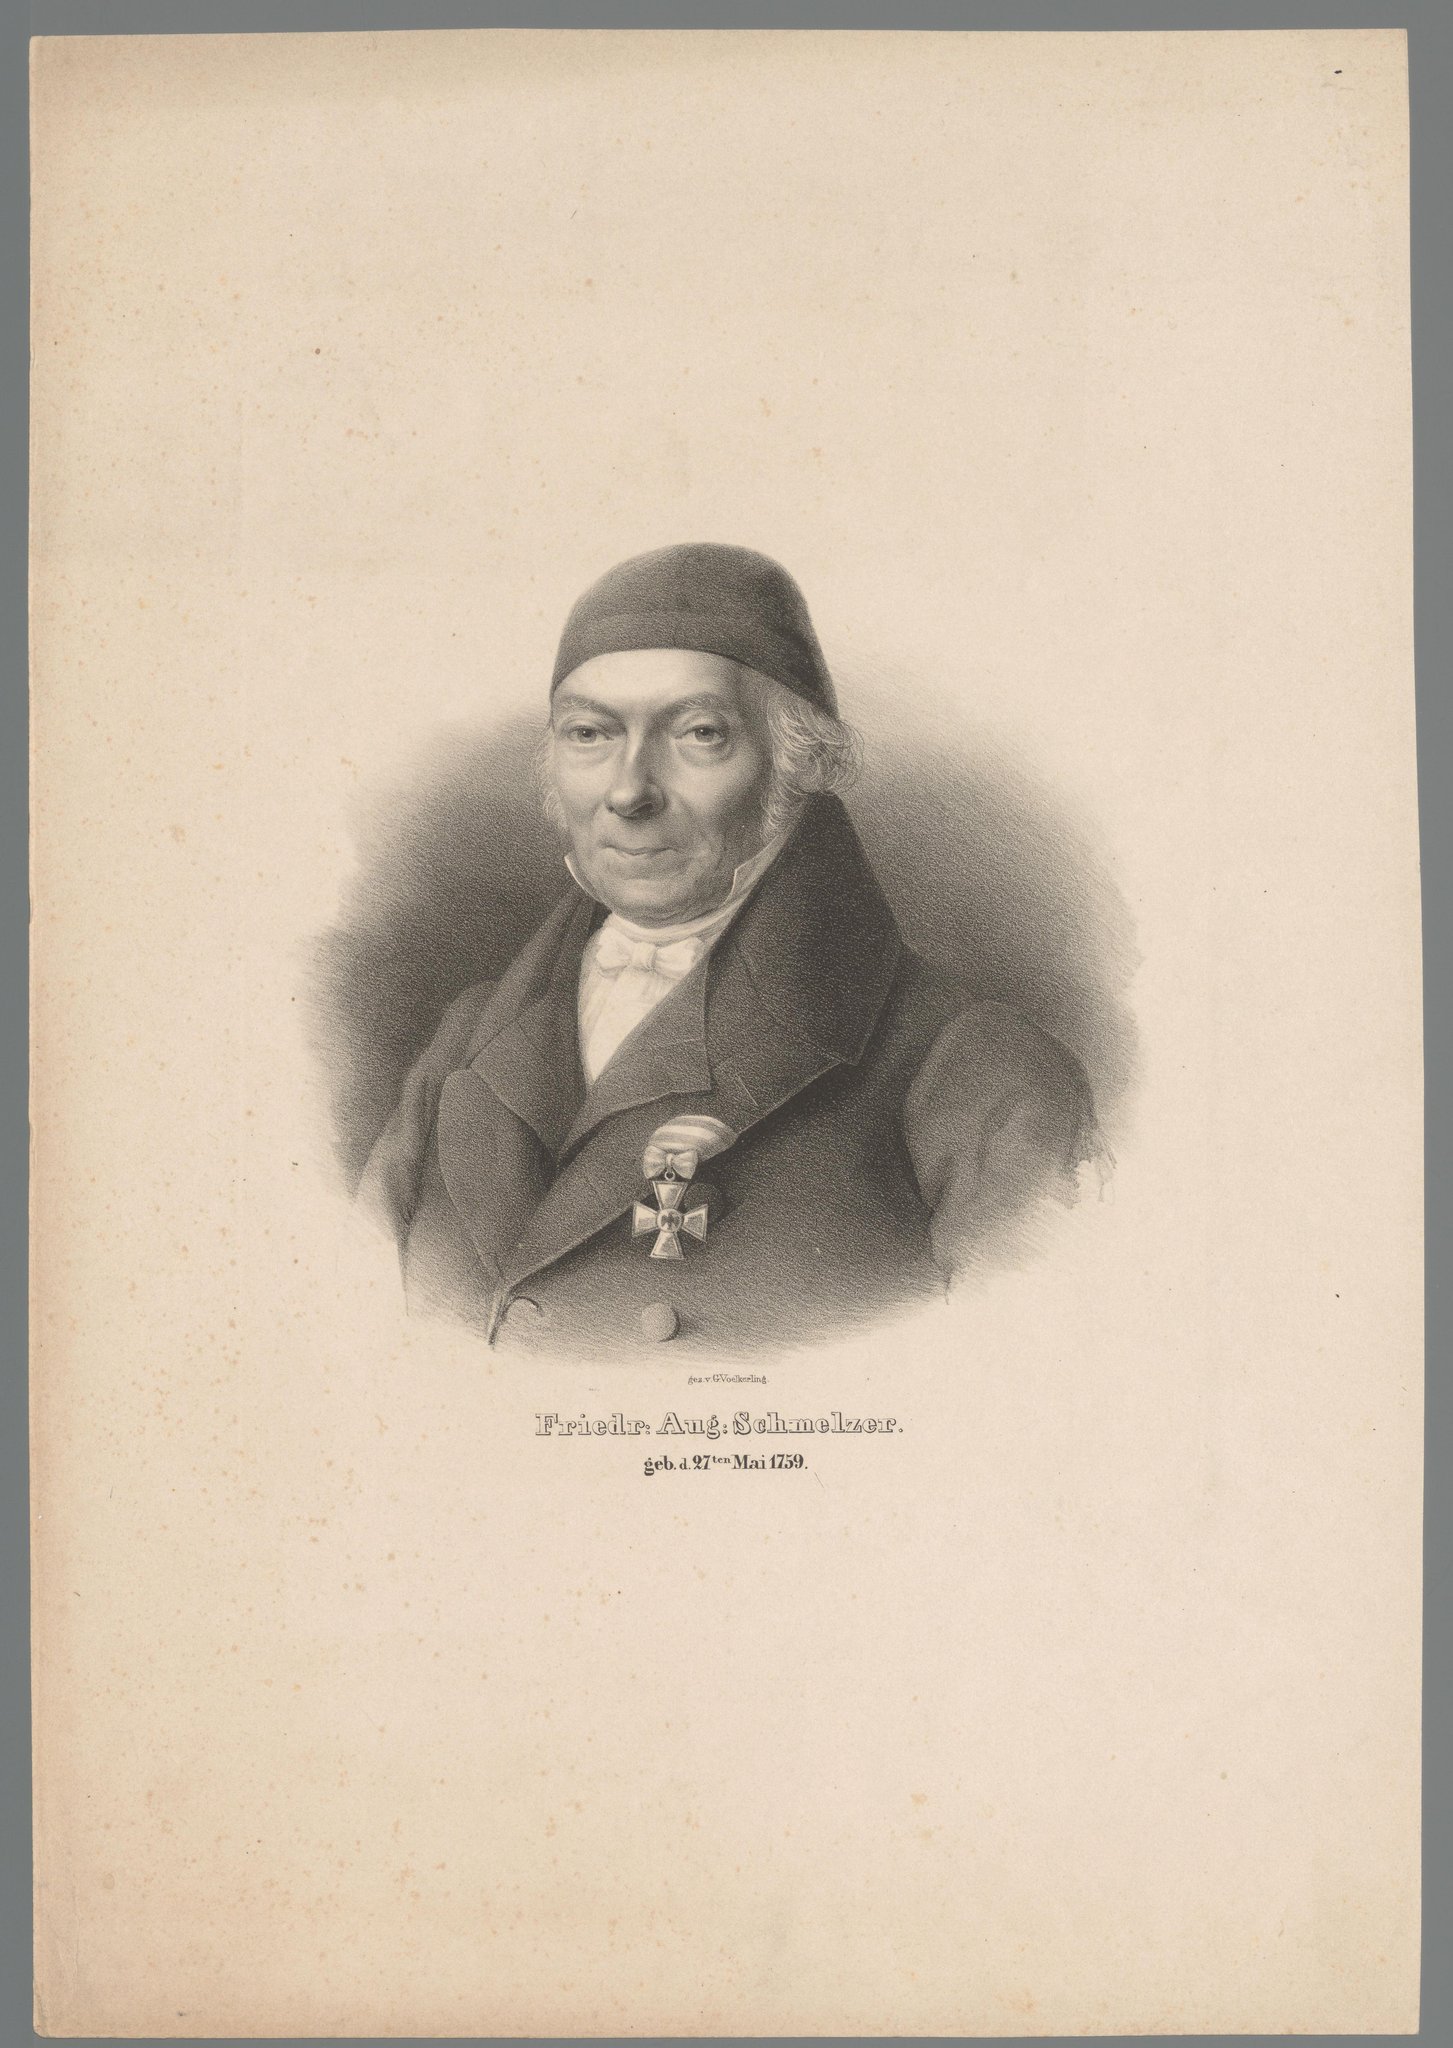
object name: print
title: Friedr. Aug. Schmelzer, geb.d. 27ten Mai 1759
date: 1820-1860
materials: paper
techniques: lithograph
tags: head-gear, adult man, historical persons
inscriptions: collector's mark: Lugt 2228